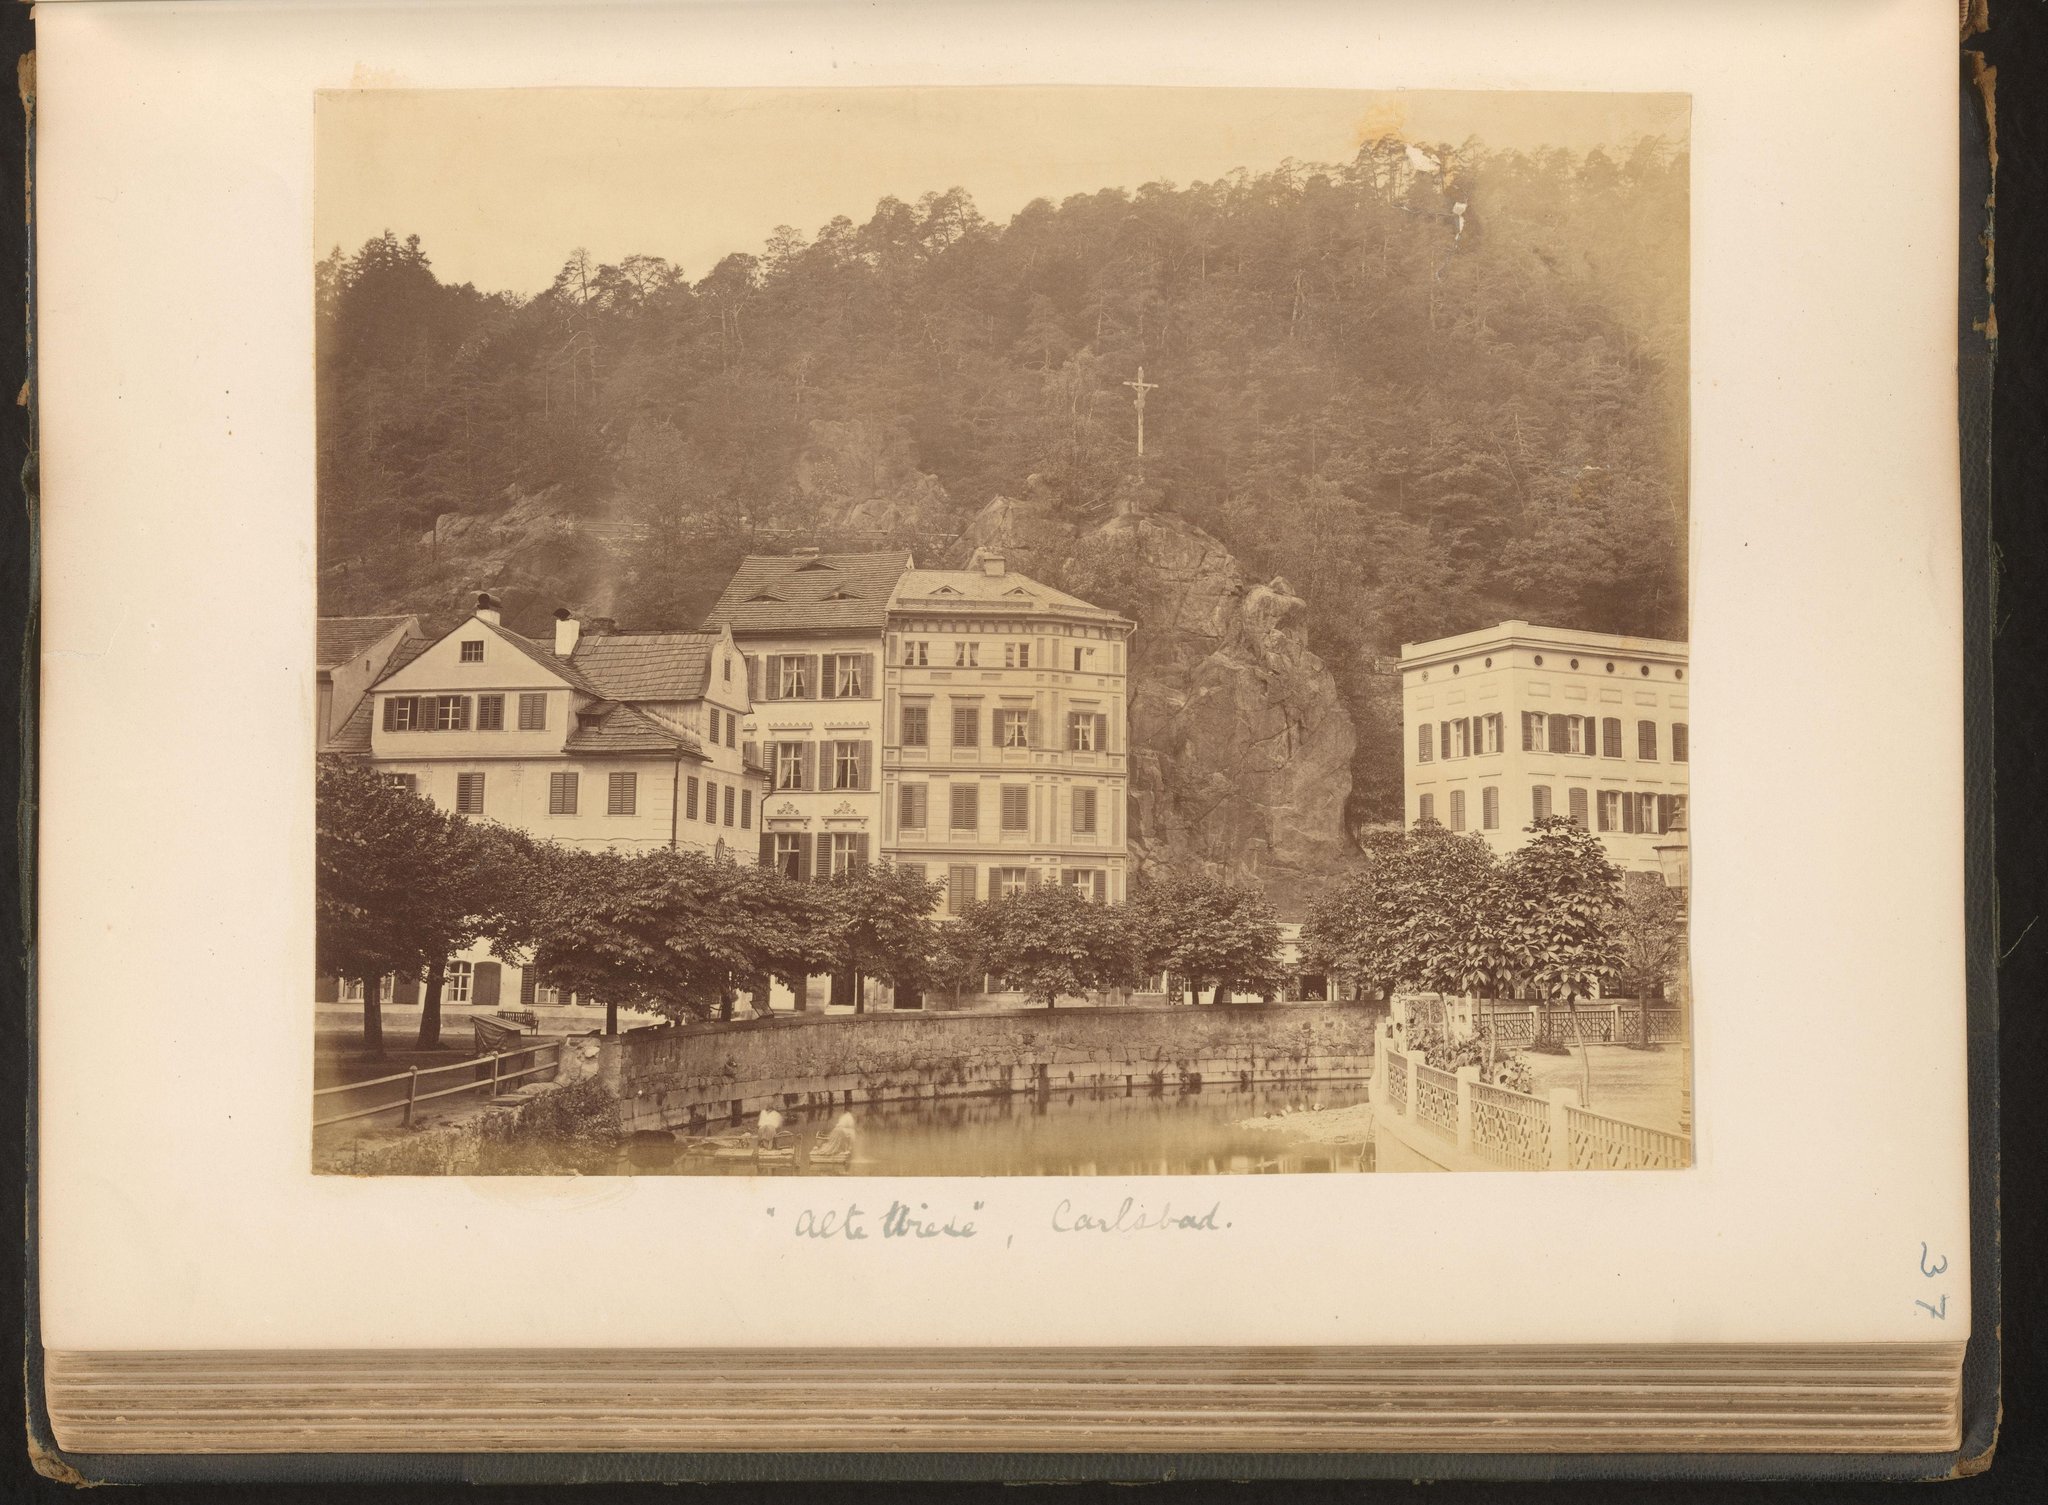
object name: album leaf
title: Gezicht op Karlovy Vary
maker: Anonymous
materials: paper, photographic support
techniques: albumen print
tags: trees, city-view in general; 'veduta', civic architecture; edifices; dwellings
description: Deze pagina maakt deel uit van een album.